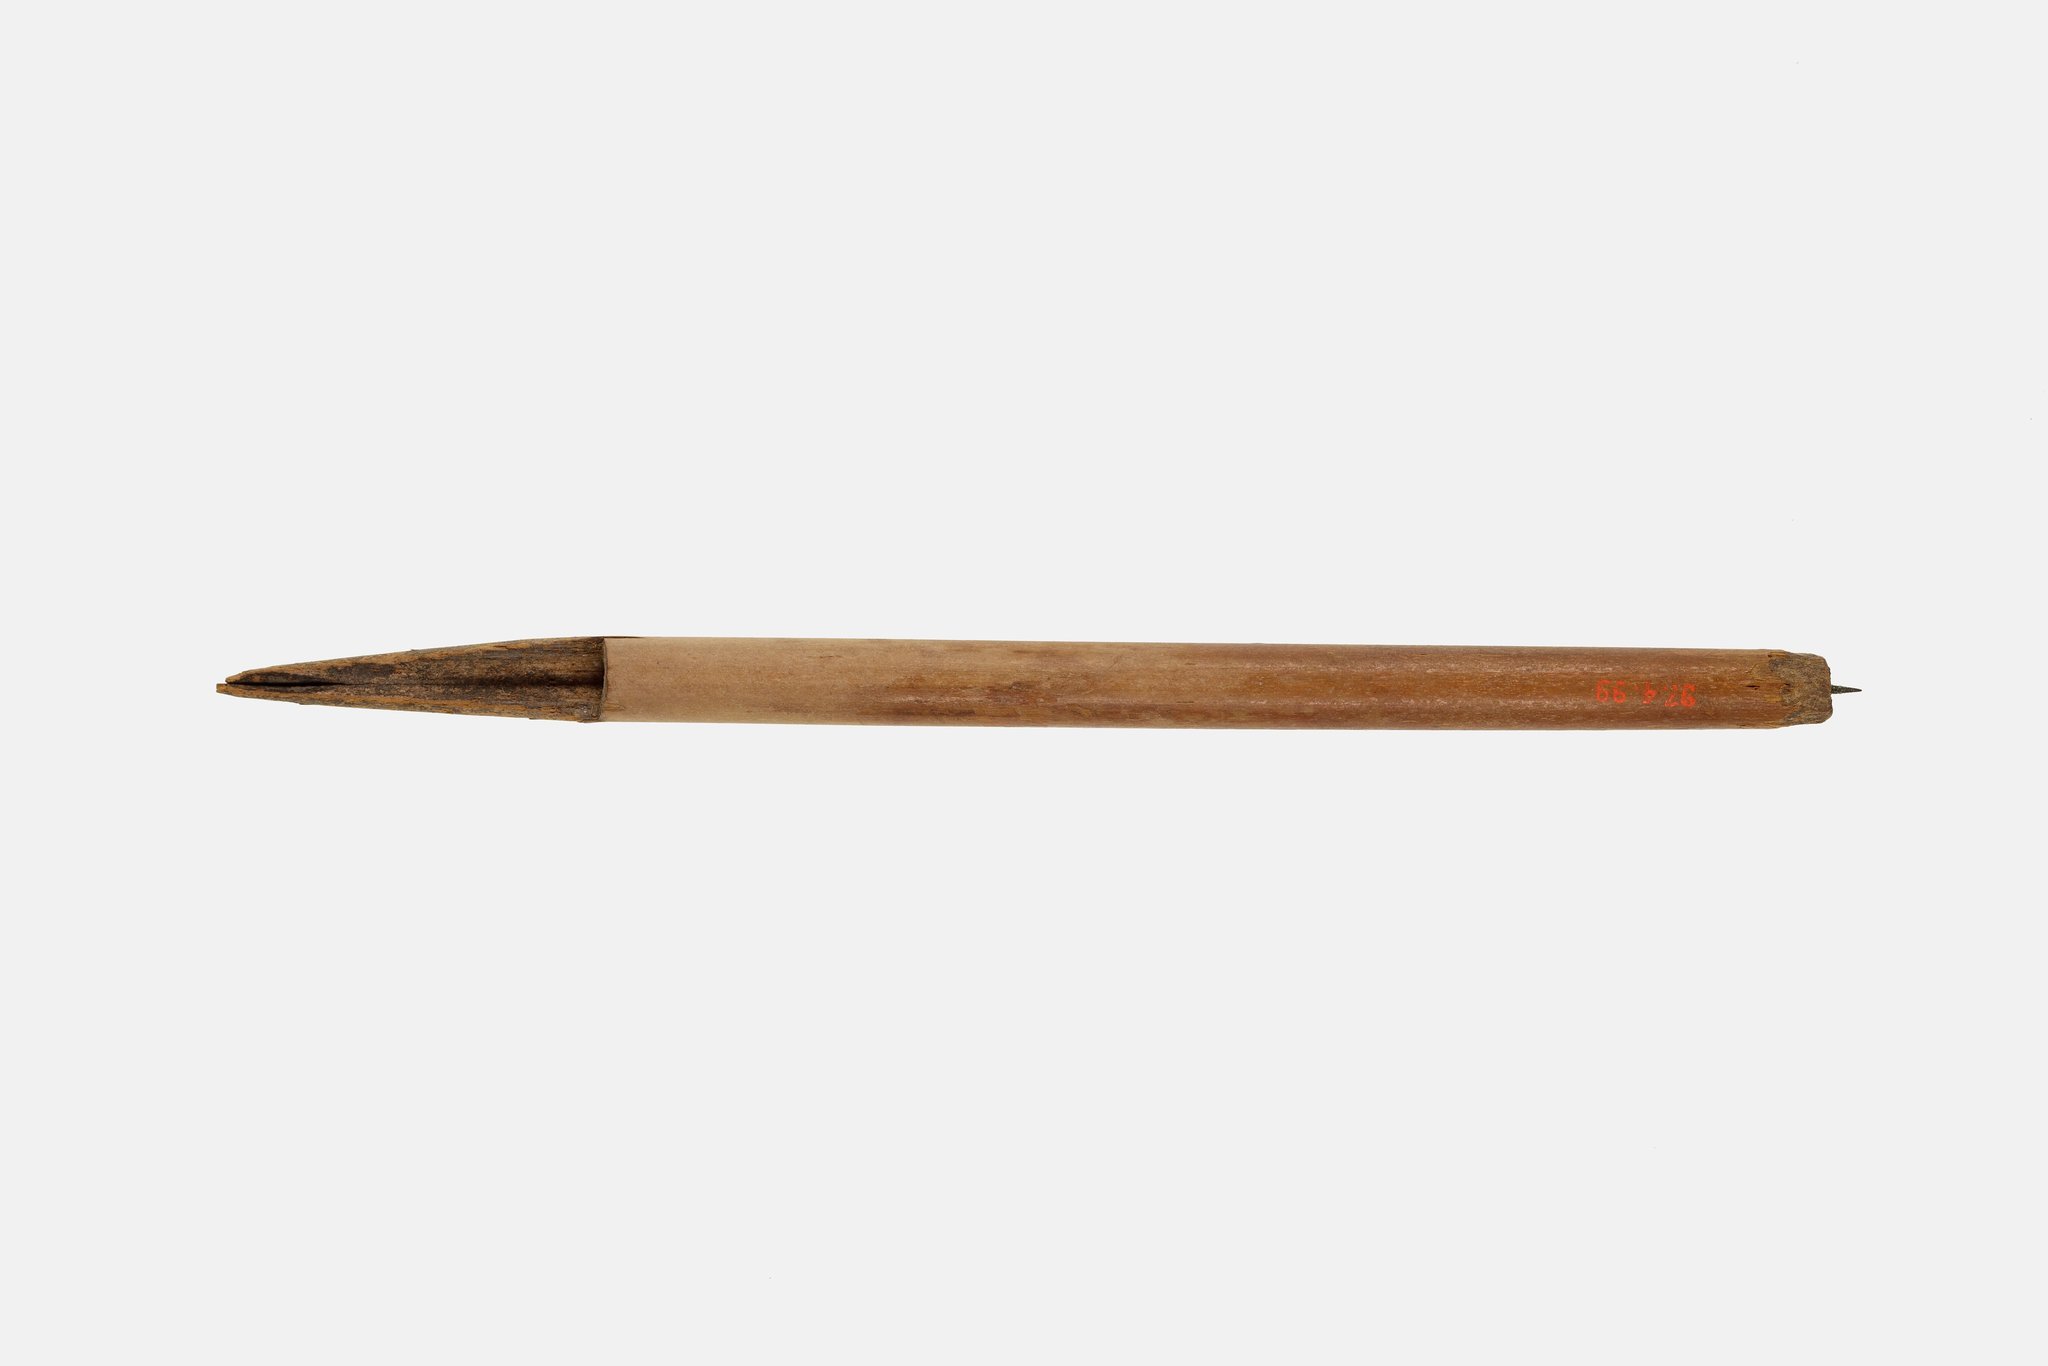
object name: pen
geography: egypt